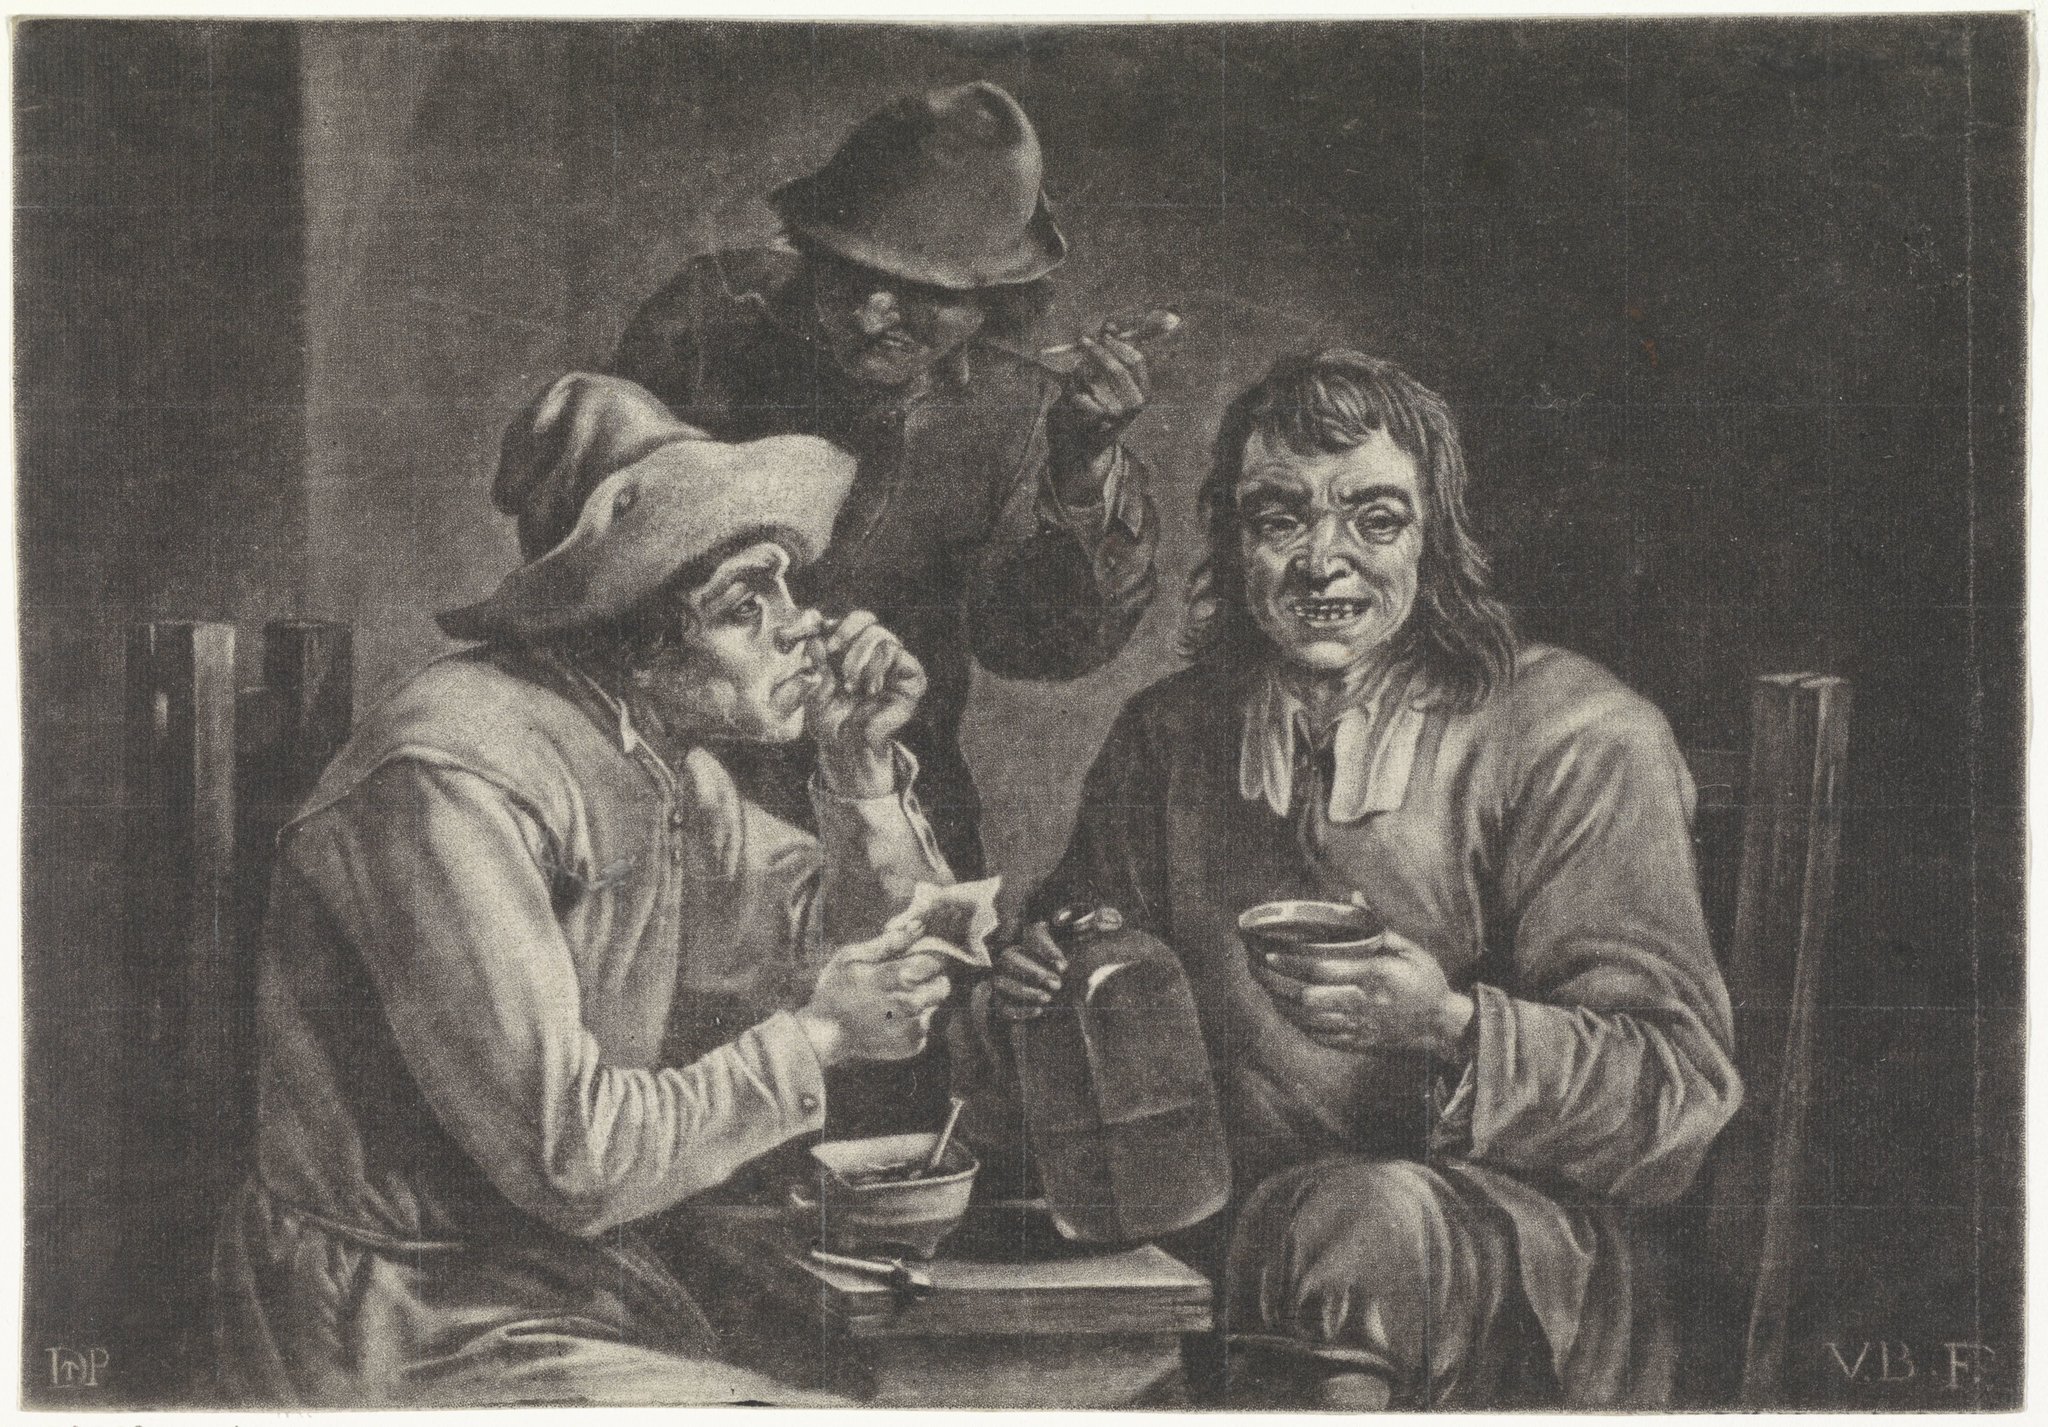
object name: print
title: Snuivende, drinkende en rokende mannen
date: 1659-1740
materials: paper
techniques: mezzotint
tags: pipe ~ tobacco, alcoholic drinks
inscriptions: collector's mark: Lugt 2228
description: In een vertrek zitten drie mannen rond een tafeltje. Een van de mannen neemt een snuifje, een ander rookt zijn pijp en de laatste heeft een fles drank en een drinkschaaltje in de hand.